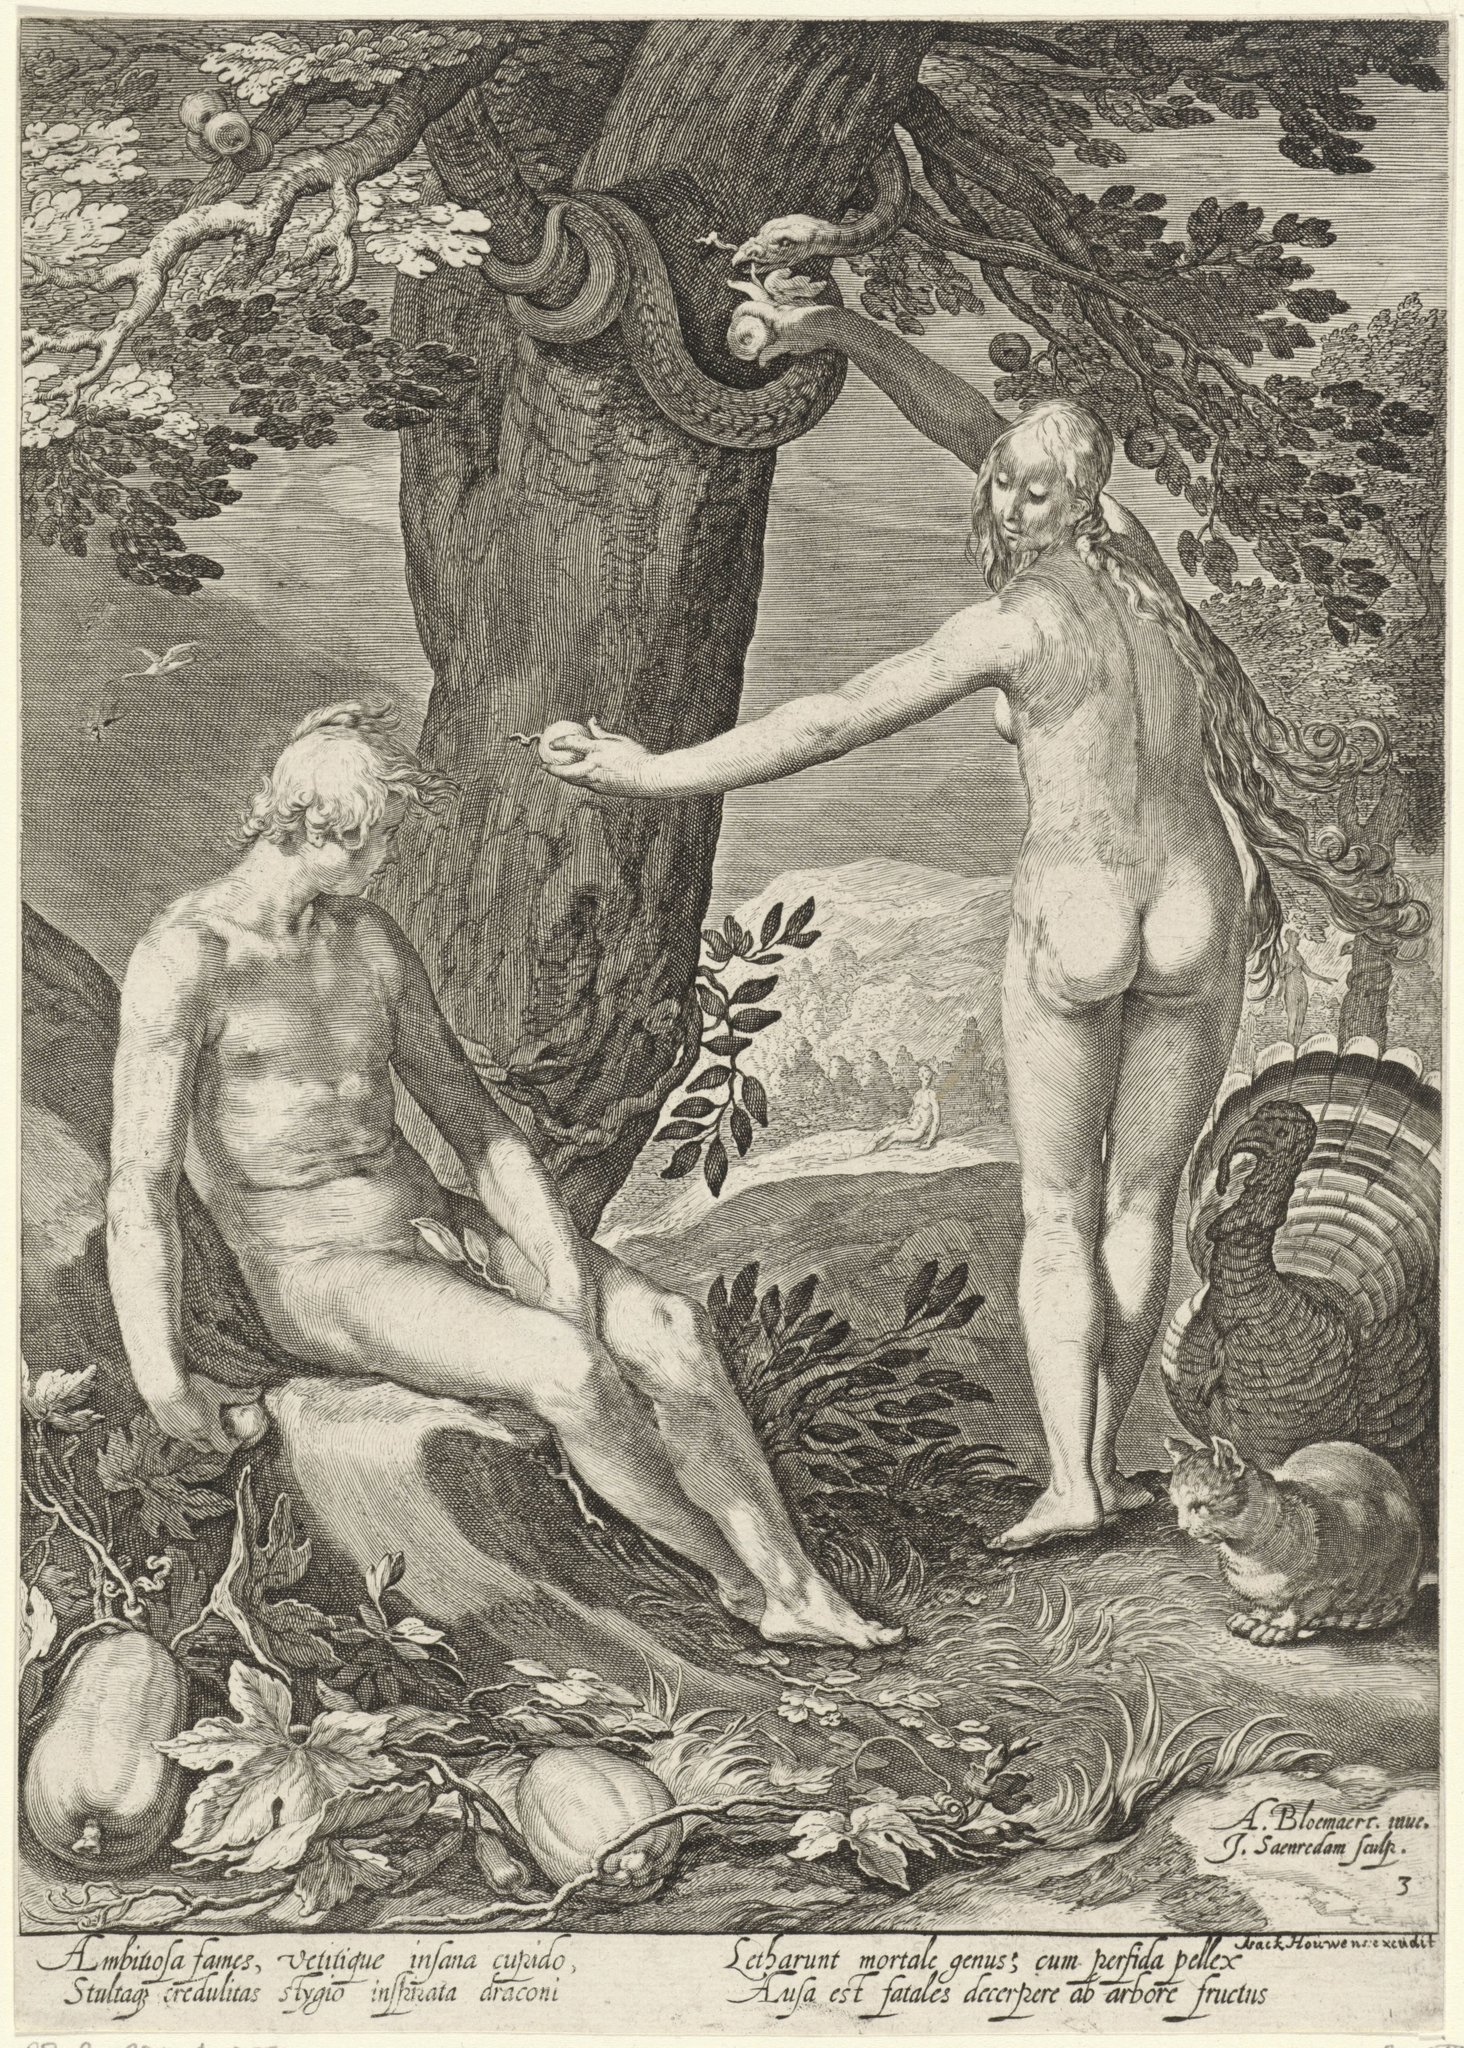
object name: print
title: Zondeval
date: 1604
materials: paper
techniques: engraving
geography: assendelft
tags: eve simultaneously offers some of the fruit to adam and takes some more from the serpent (or the tree), cat, the serpent tries to persuade eve to take some of the fruit (usually an apple), walker and runner birds: turkey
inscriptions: collector's mark: Lugt 2228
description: Eva biedt Adam een appel aan van de boom der kennis van goed en kwaad. Rond de stam van de boom is een slang gekronkeld die Eva een andere appel aanreikt. Op de achtergrond wordt Eva verleid door de slang.